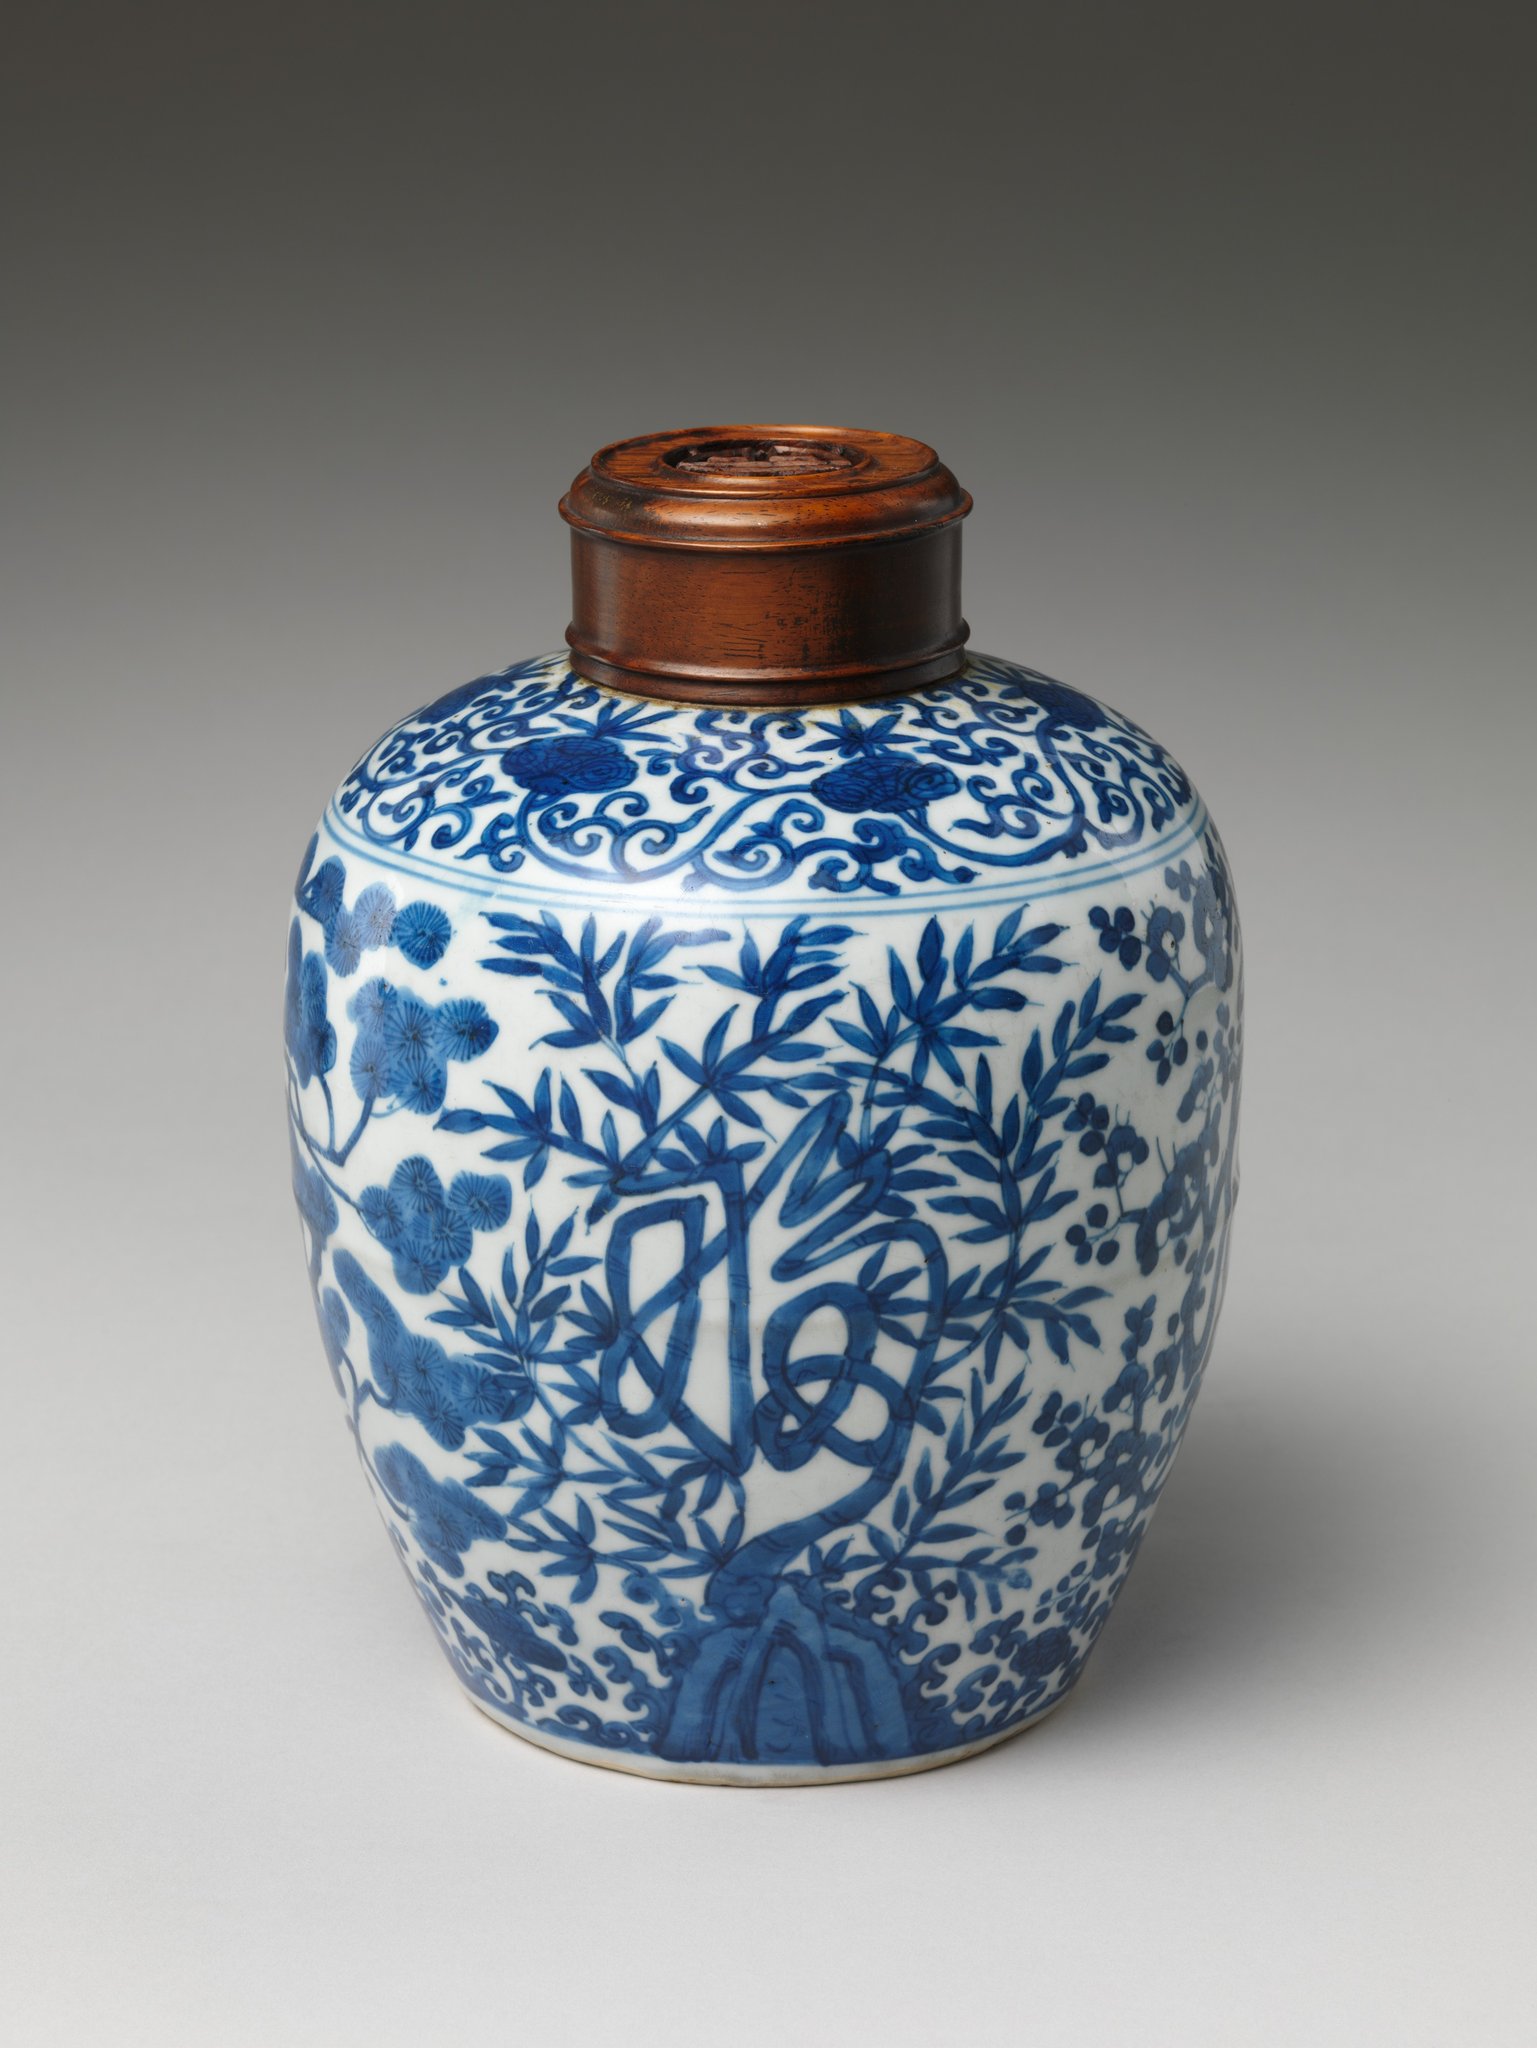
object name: pot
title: Jar decorated with auspicious characters amid plants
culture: chinese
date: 1567-1600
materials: cobalt, porcelain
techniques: painting, underglaze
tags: flowers,trees